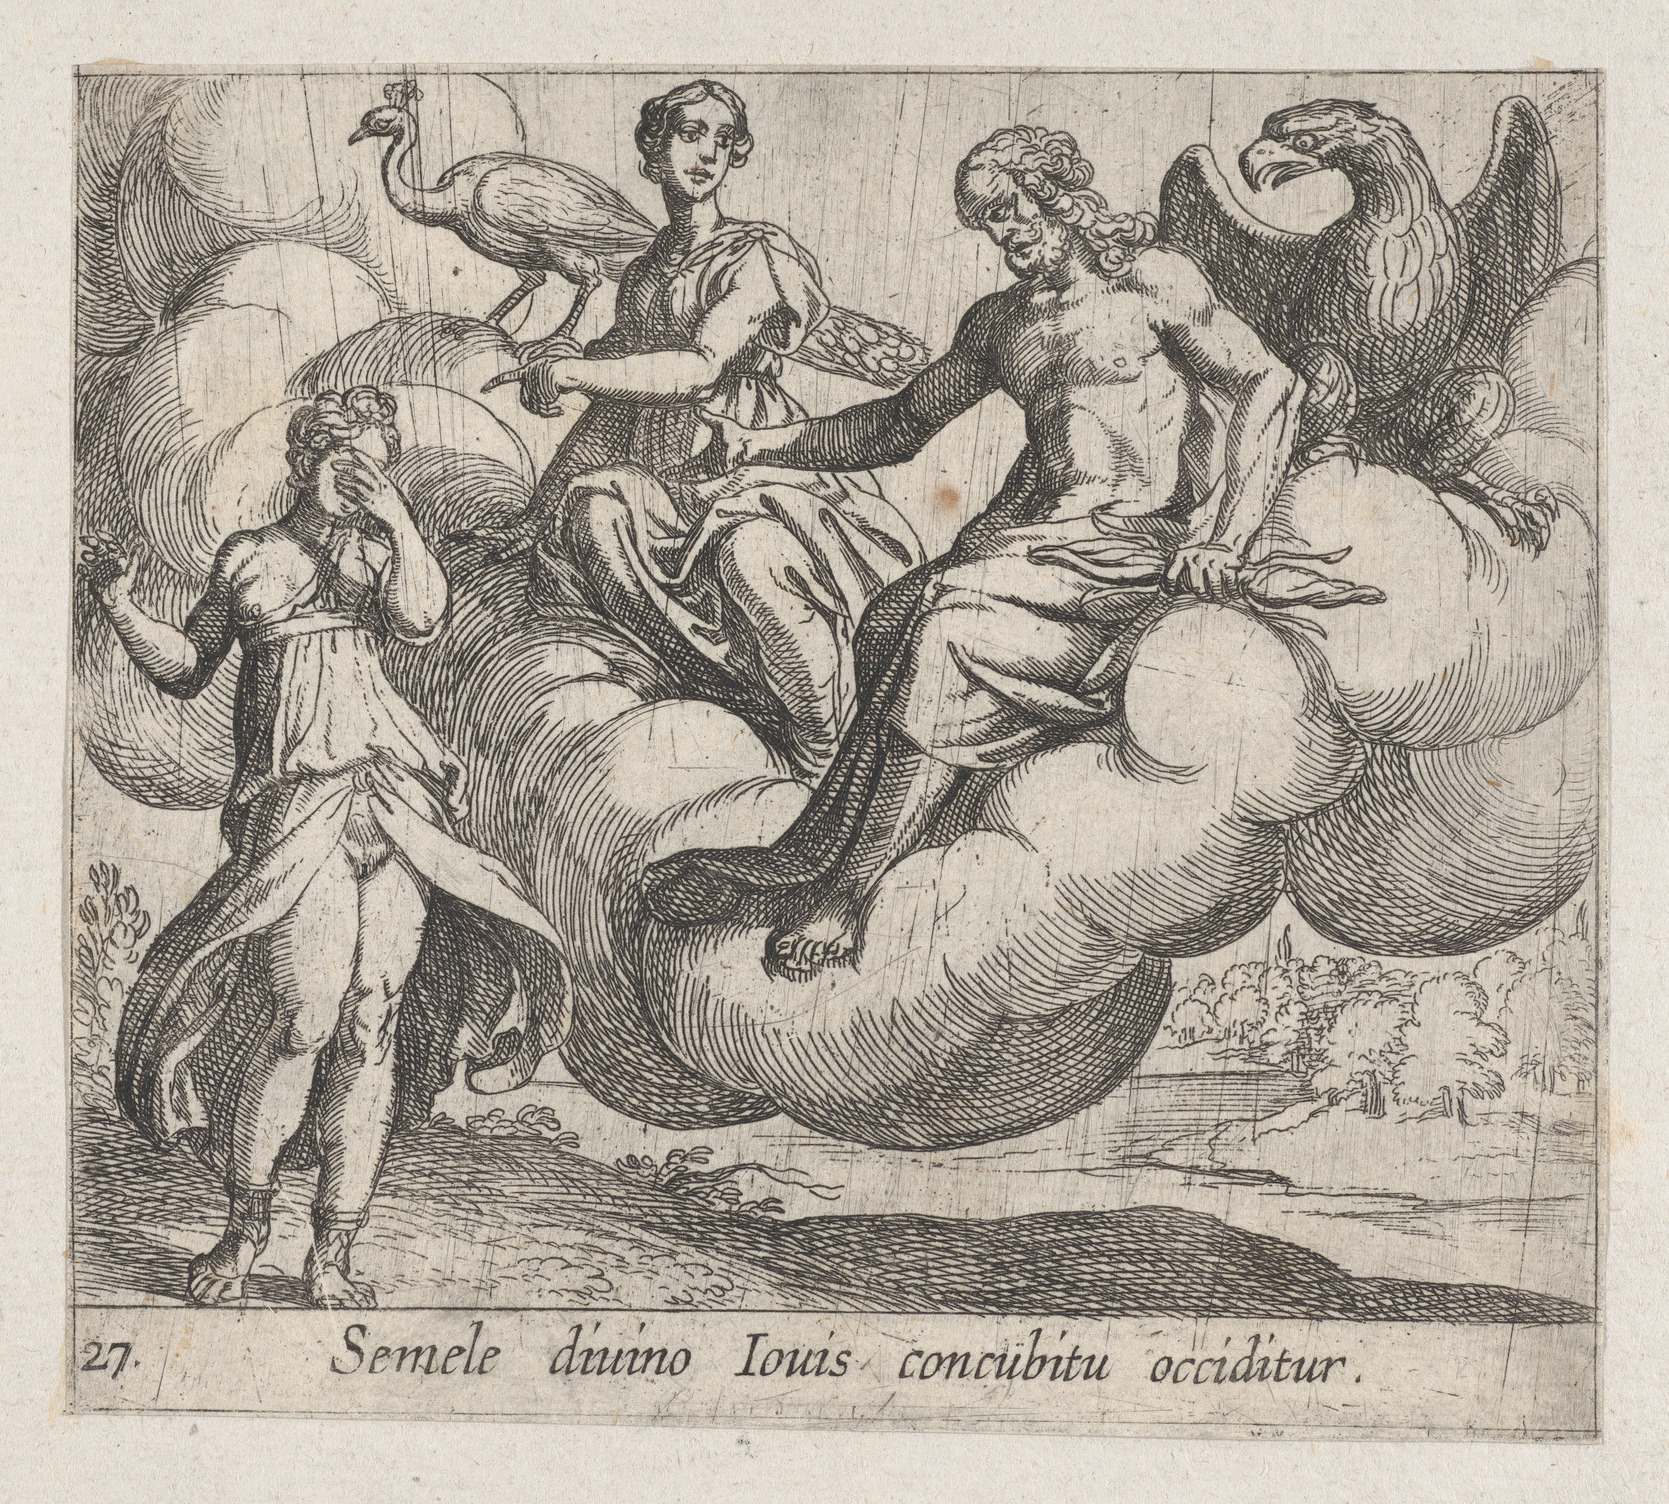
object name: print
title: Plate 27: Semele's Wish (Semele divino Ious concubitu occiditur), from Ovid's 'Metamorphoses'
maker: antonio tempesta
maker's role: artist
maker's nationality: italian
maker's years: 1555-1630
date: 1606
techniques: etching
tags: eagles,men,women,peacocks